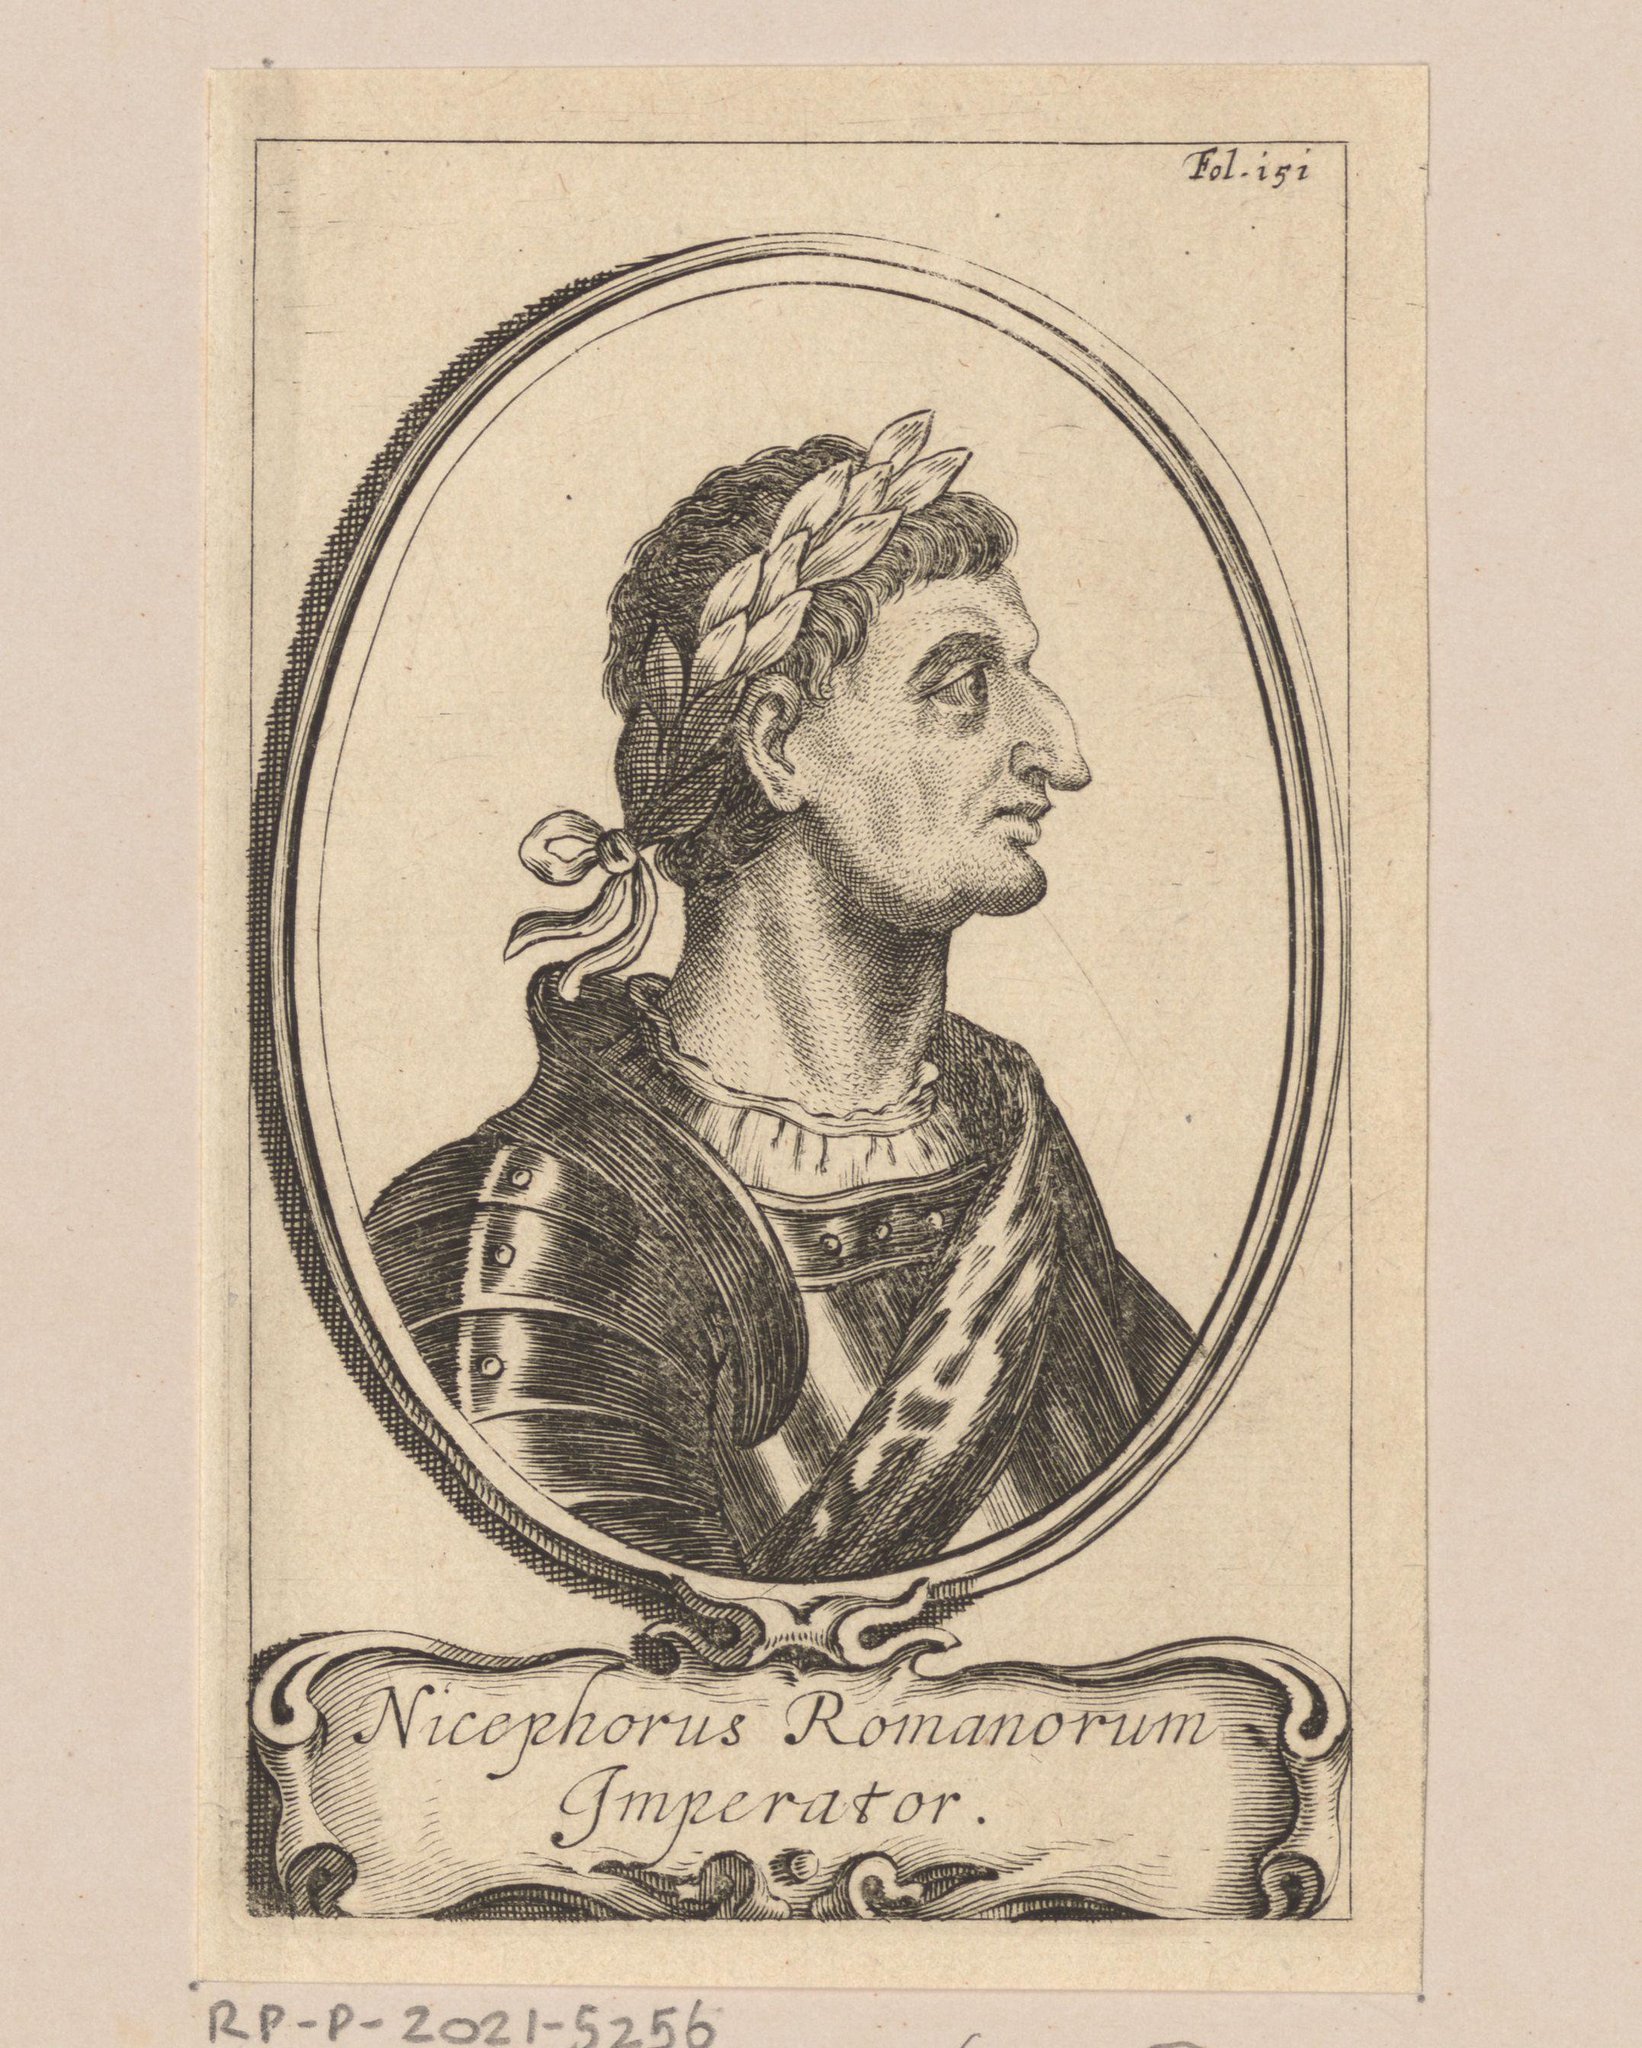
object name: print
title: Portret van Nikephoros I, keizer van het Byzantijnse rijk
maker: Anonymous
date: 1659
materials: paper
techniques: engraving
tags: historical persons, emperor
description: Prent mogelijk uit: Bos, Lambert van den. Het konincklyk treur-toonneel, ofte op- en ondergangh der keyseren, koningen en vorsten (...). Dordrecht: Jan Jacobsz. Schipper, 1659, dl. 1, fol. 151.